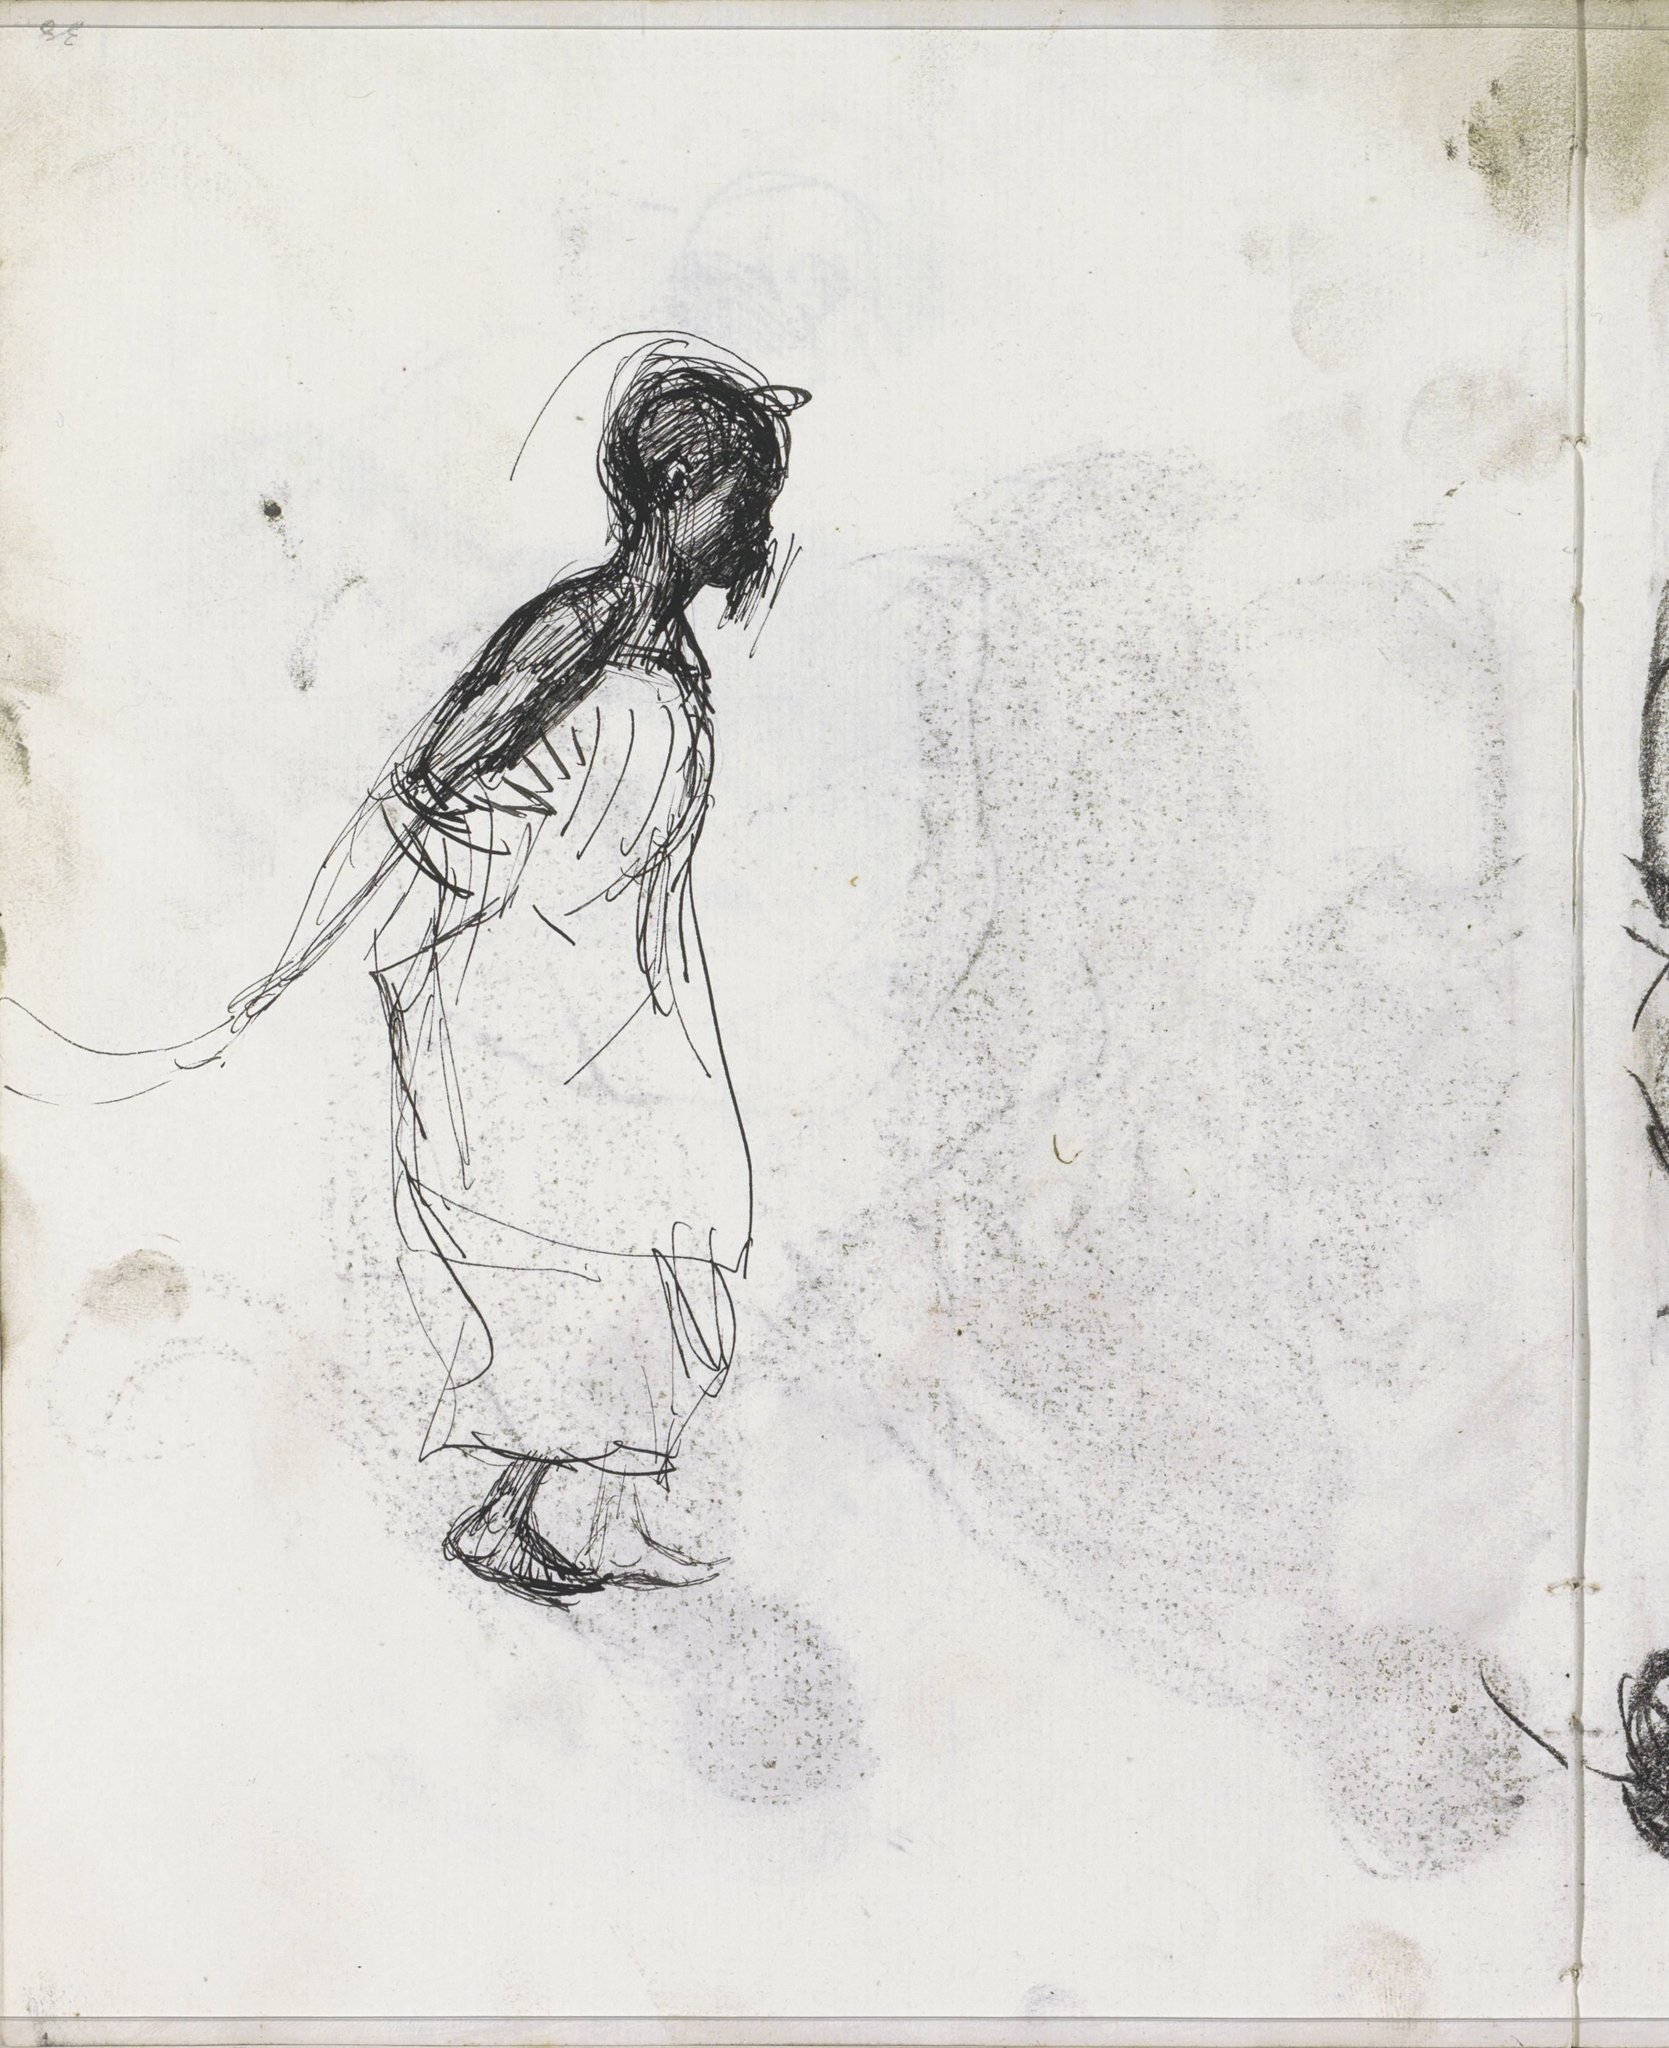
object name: sketchbook leaf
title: Vooroverbuigende Afrikaanse figuur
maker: isaac israels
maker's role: draughtsman, painter, print maker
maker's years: 1865-1934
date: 1875-1934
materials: ink, paper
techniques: pen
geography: the hague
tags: leaning forward, dancing, africans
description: Mogelijk een danser. Blad 13 verso uit schetsboek XIII met 25 bladen.